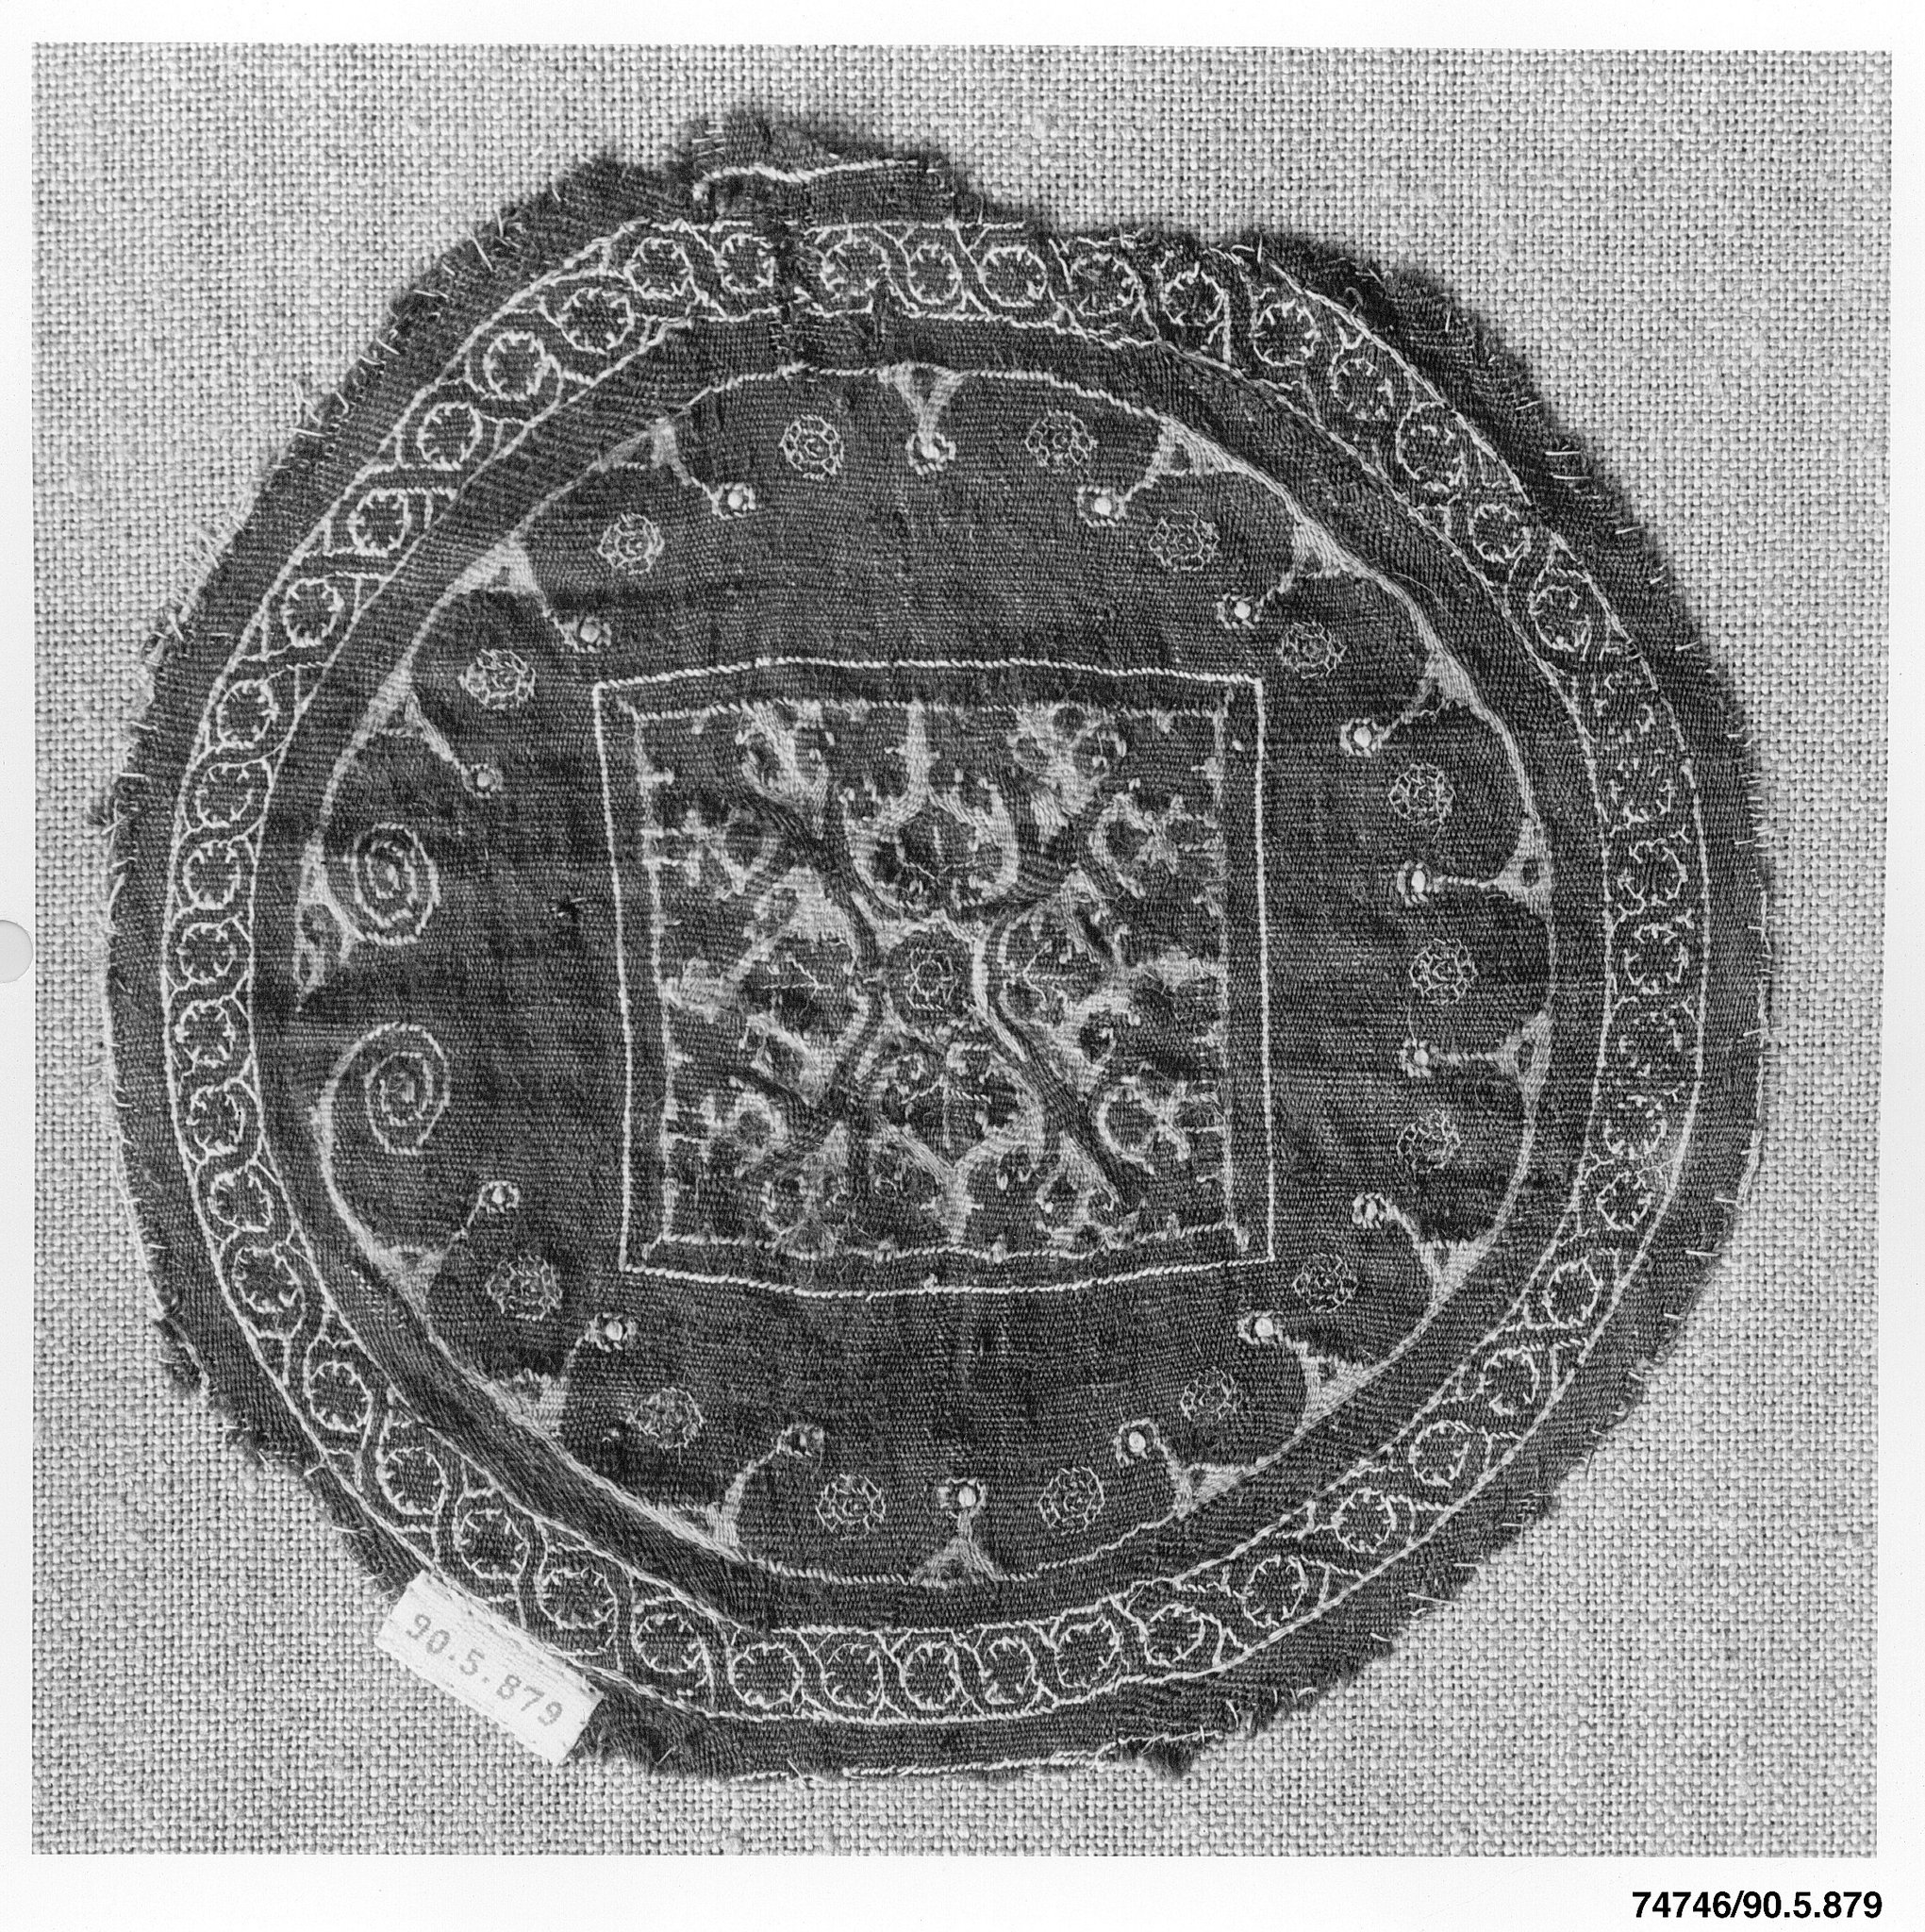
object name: roundel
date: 201-400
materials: linen, wool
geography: egypt